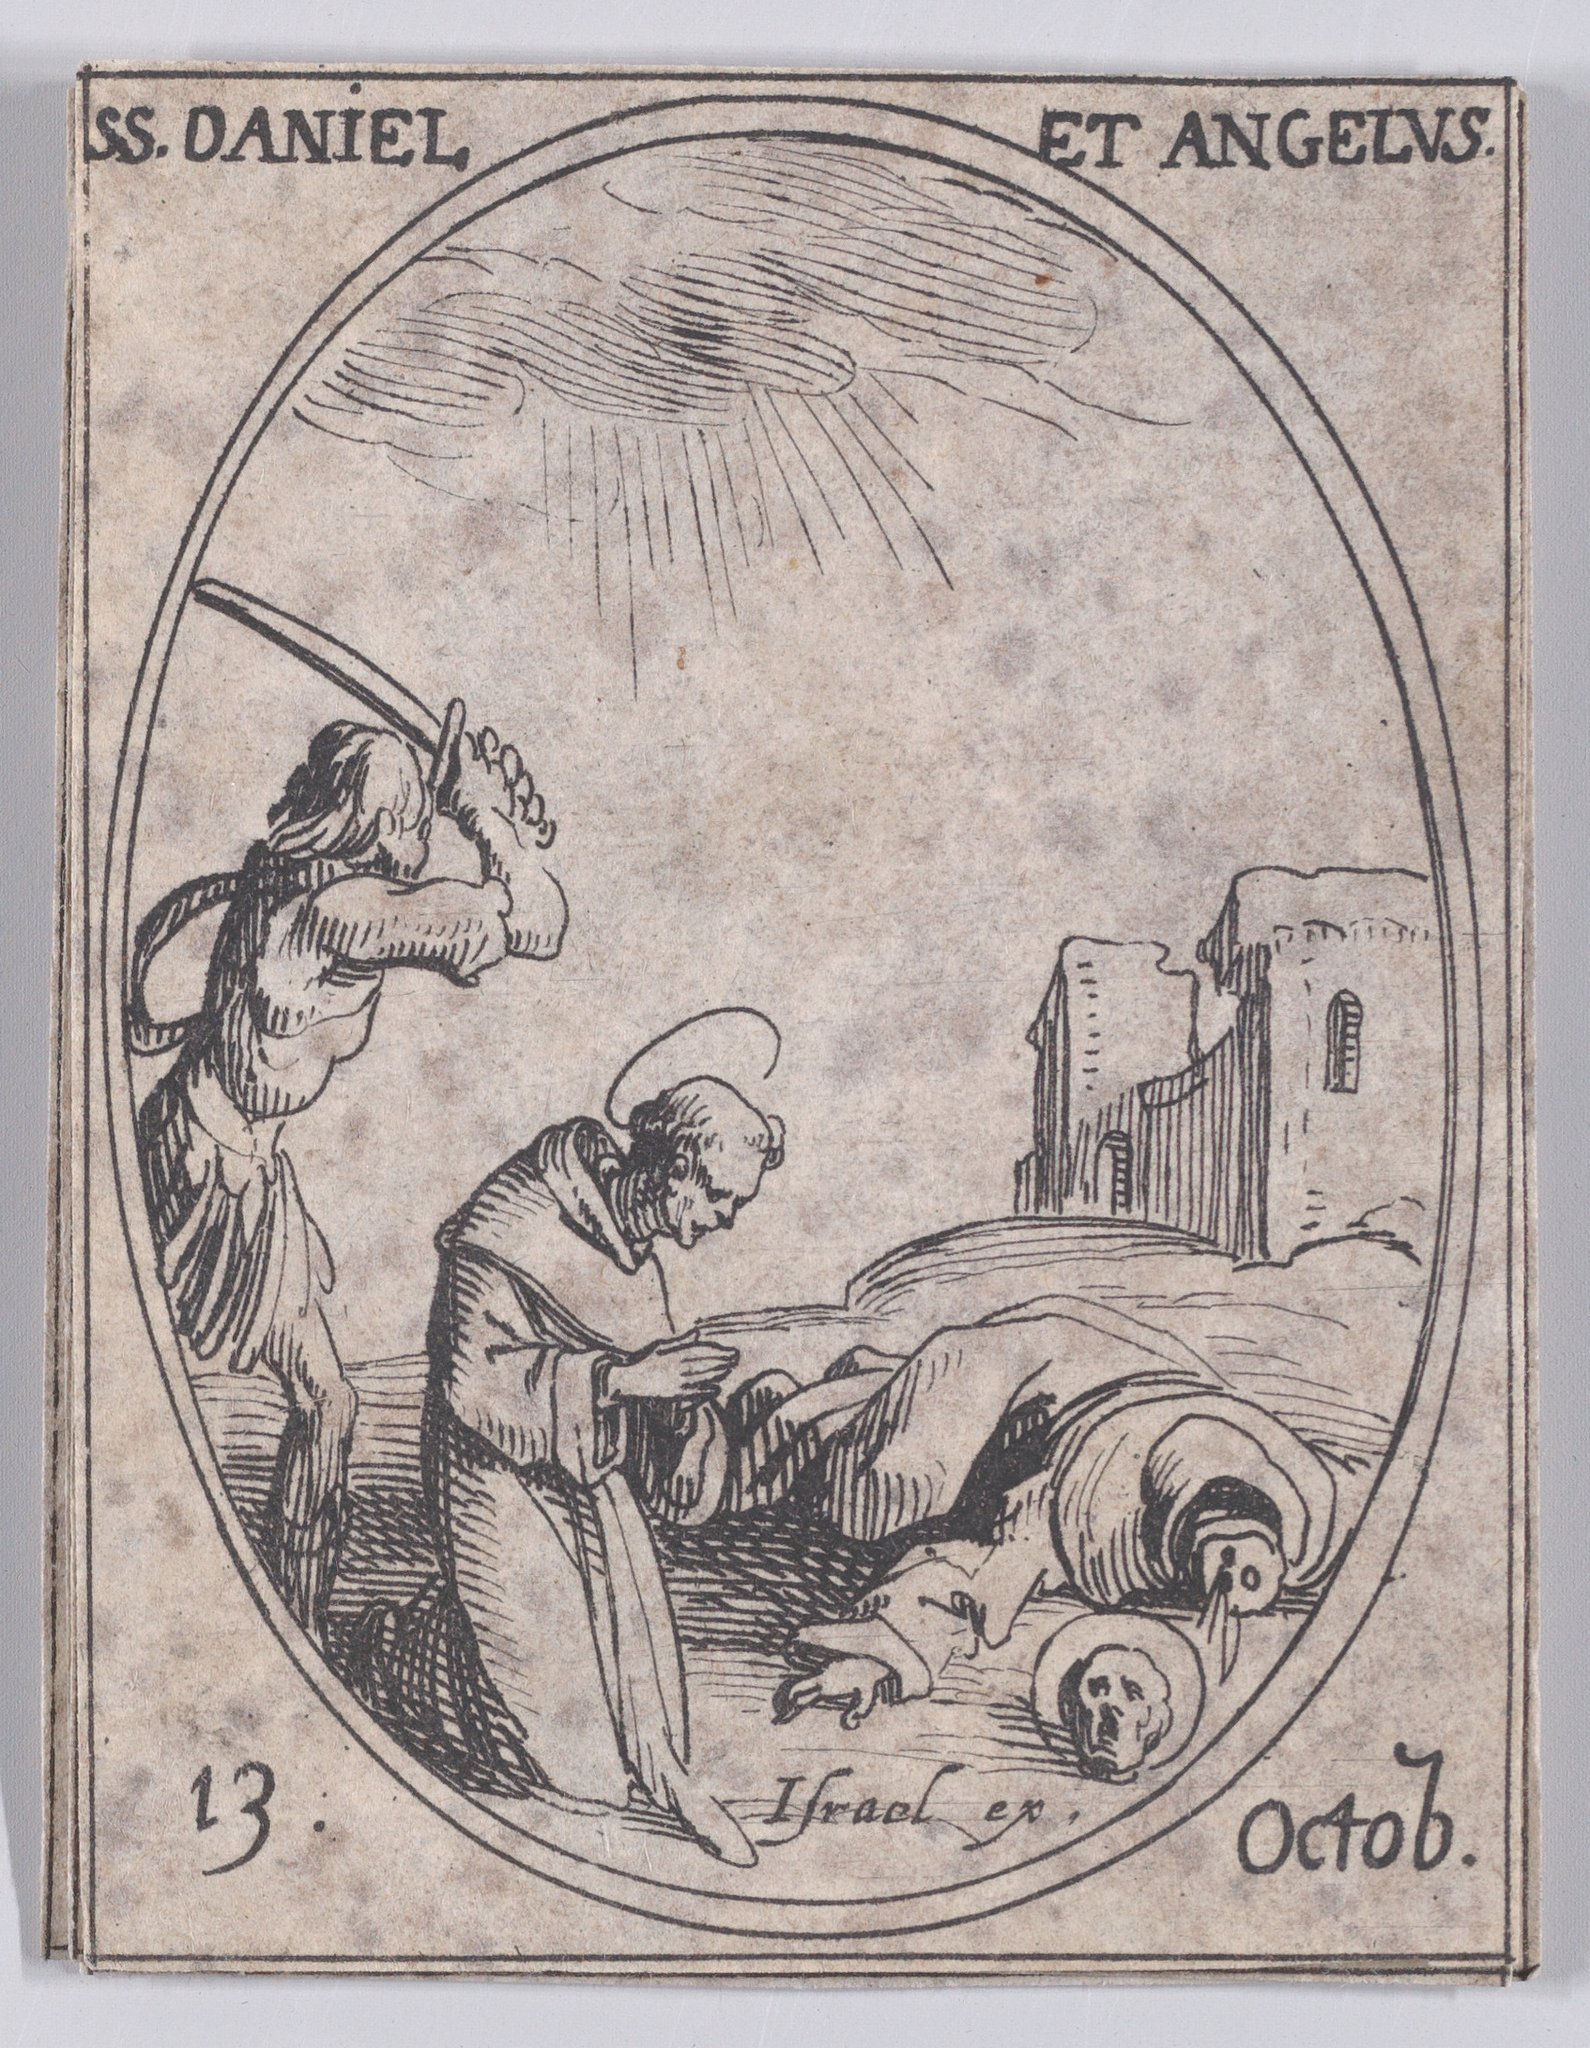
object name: print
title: S. Daniel et S. Ange (St. Daniel and St. Angelus), October 13th, from "Les Images De Tous Les Saincts et Saintes de L'Année" (Images of All of the Saints and Religious Events of the Year)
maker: jacques callot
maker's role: artist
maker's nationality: french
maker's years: 1592-1635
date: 1636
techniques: etching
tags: men,saints